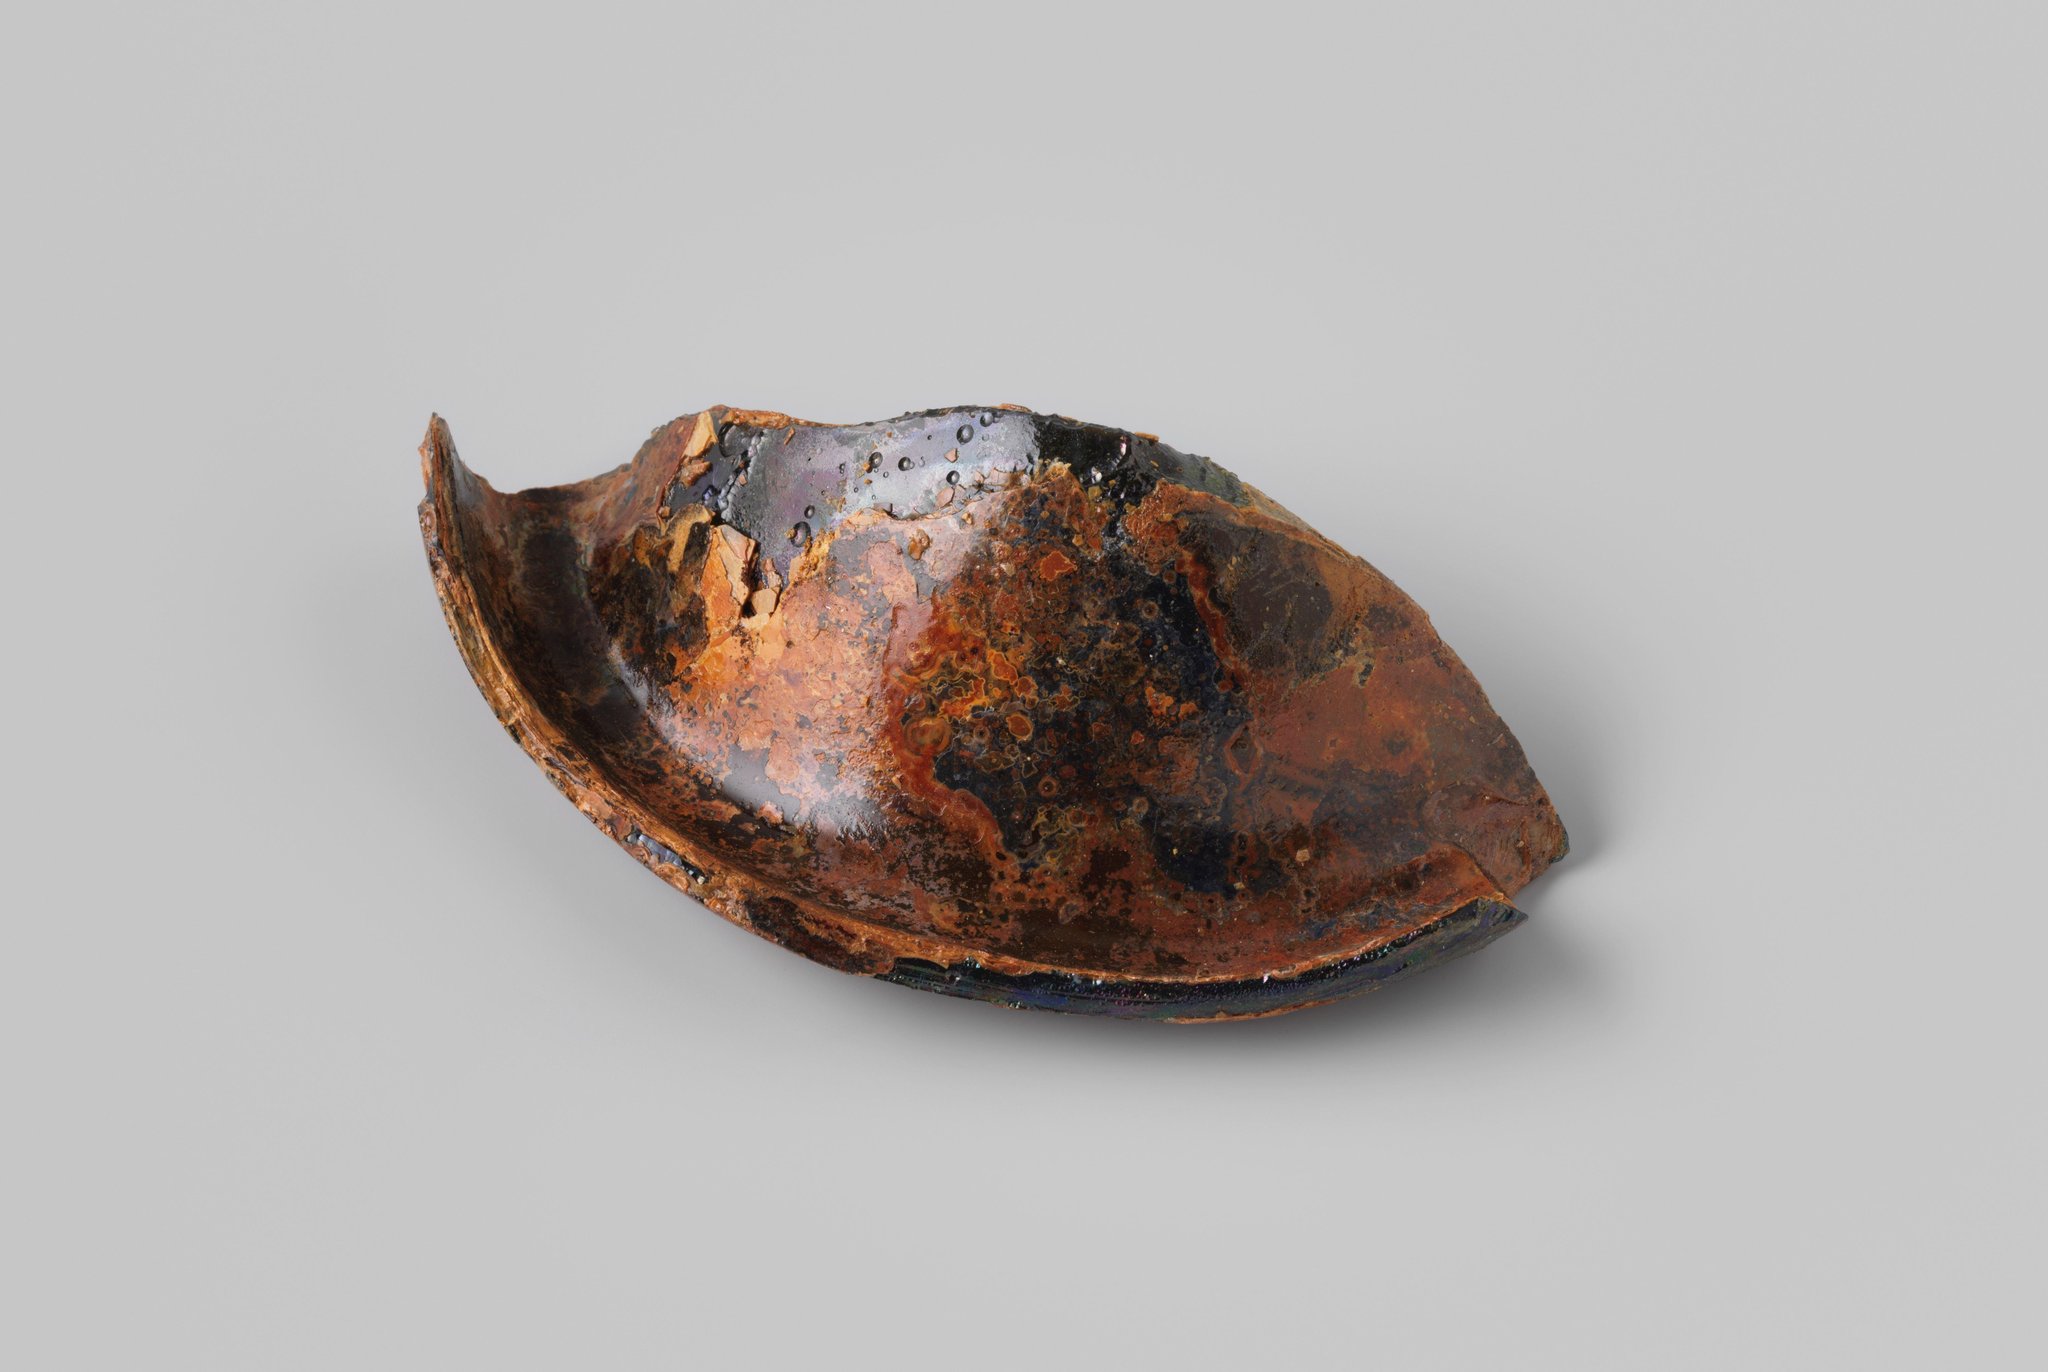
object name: sherd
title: Scherf van een wijnfles uit het wrak van de Oost-Indiëvaarder 't Vliegend Hart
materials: glass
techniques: green glass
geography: netherlands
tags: 't vliegend hart (schip), verenigde oostindische compagnie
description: Scherf van een uivormige wijnflessen van groen glas waar rode (port)wijn in heeft gezeten.